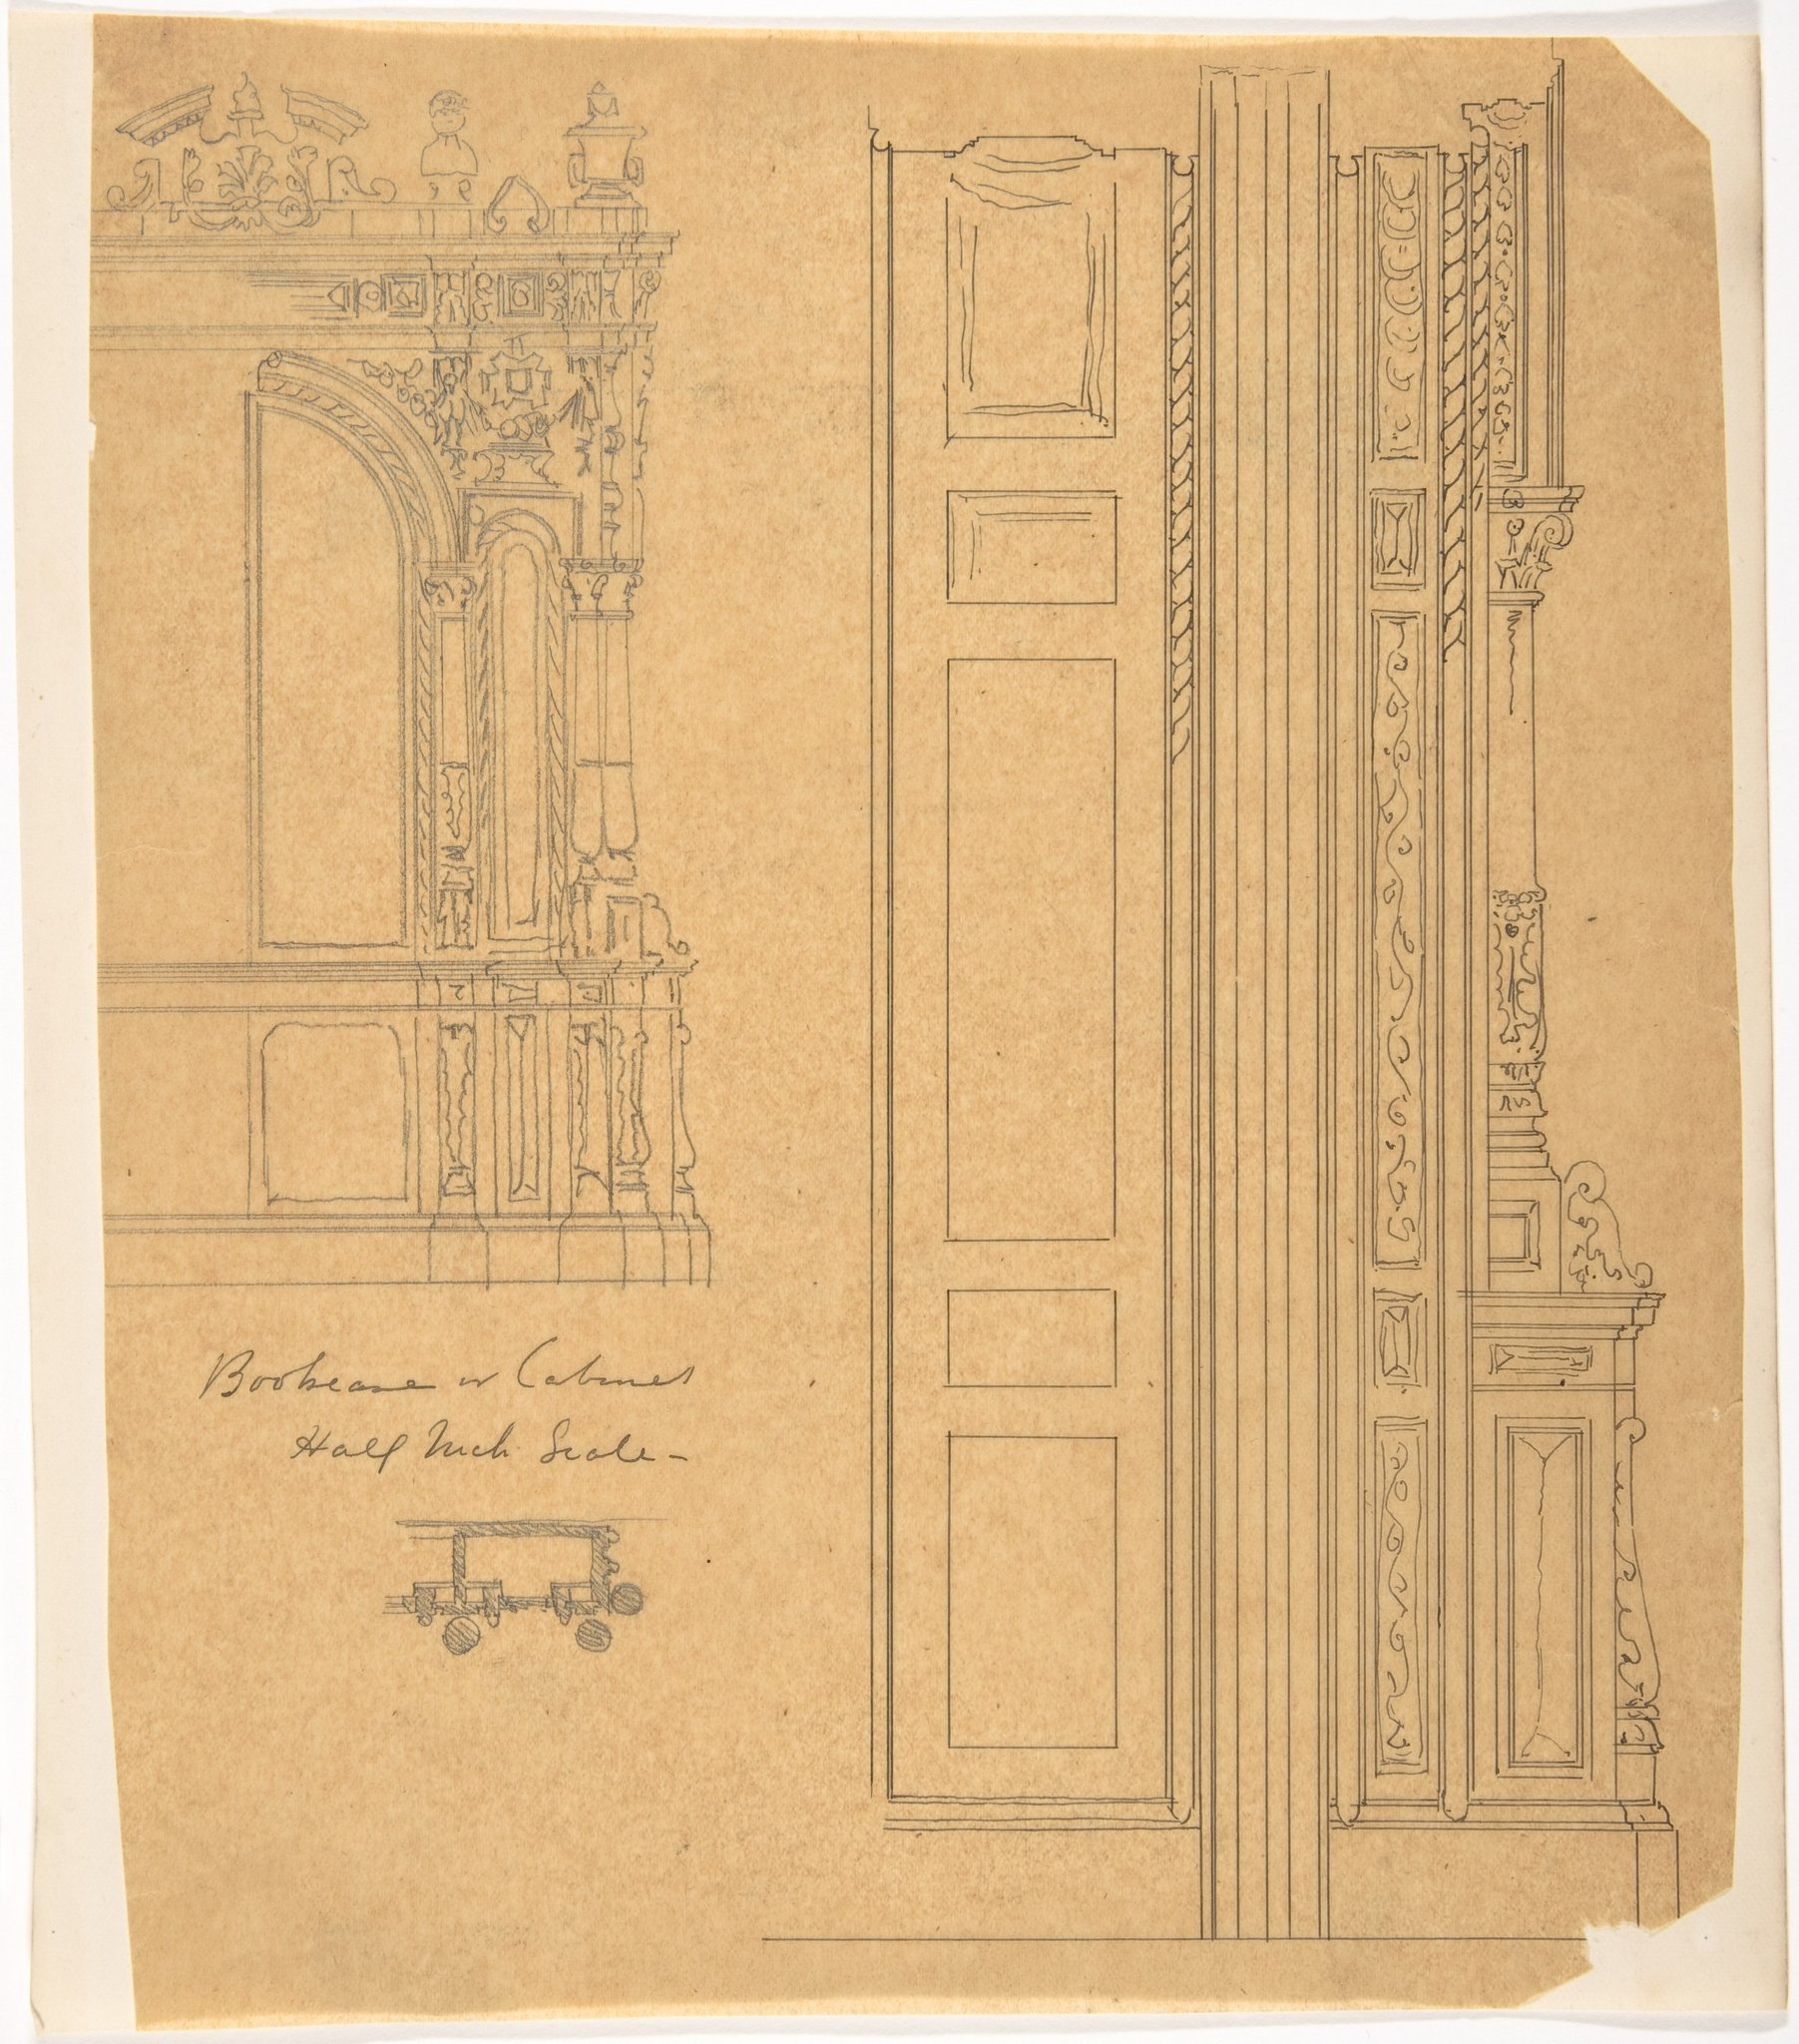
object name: drawing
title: Bookcase of Cabinet Design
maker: anonymous, british, 19th century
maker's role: artist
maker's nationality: british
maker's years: 1800-1900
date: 1801-1900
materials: ink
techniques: pen